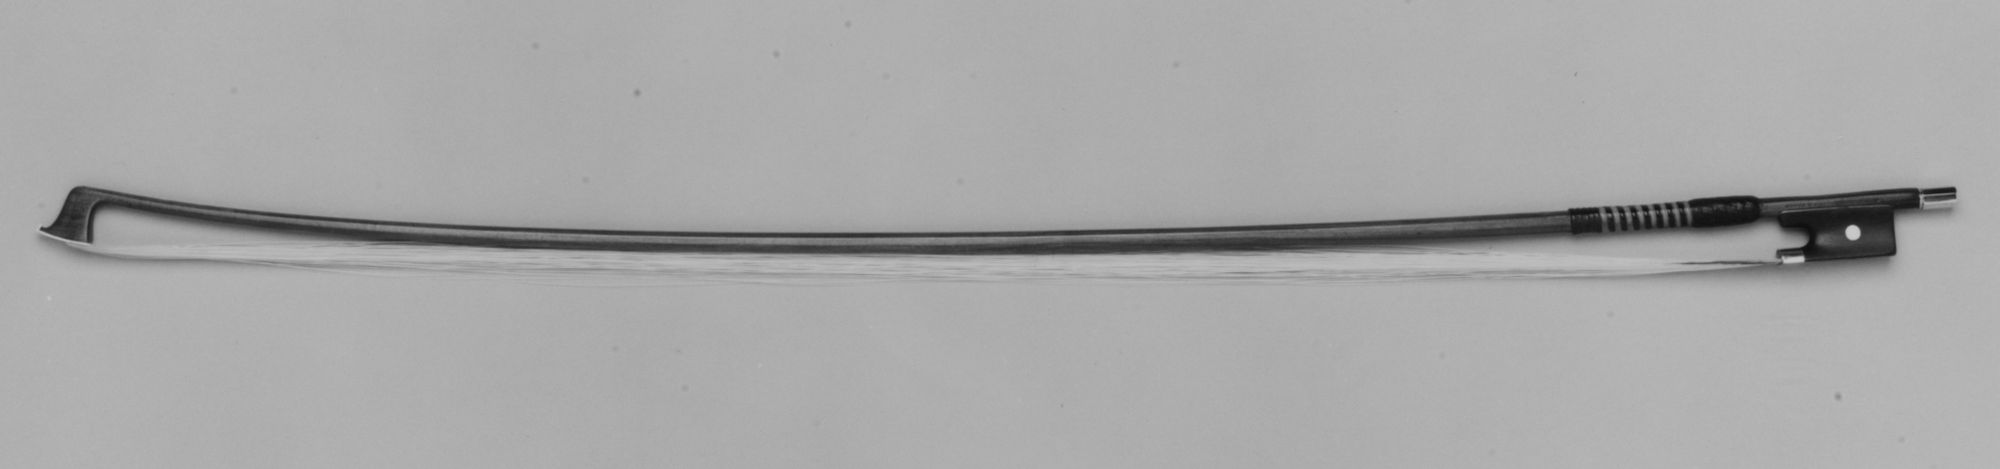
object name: bow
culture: french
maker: alfred joseph lamy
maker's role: maker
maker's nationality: french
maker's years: 1850-1919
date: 1900-1920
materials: wood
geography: france